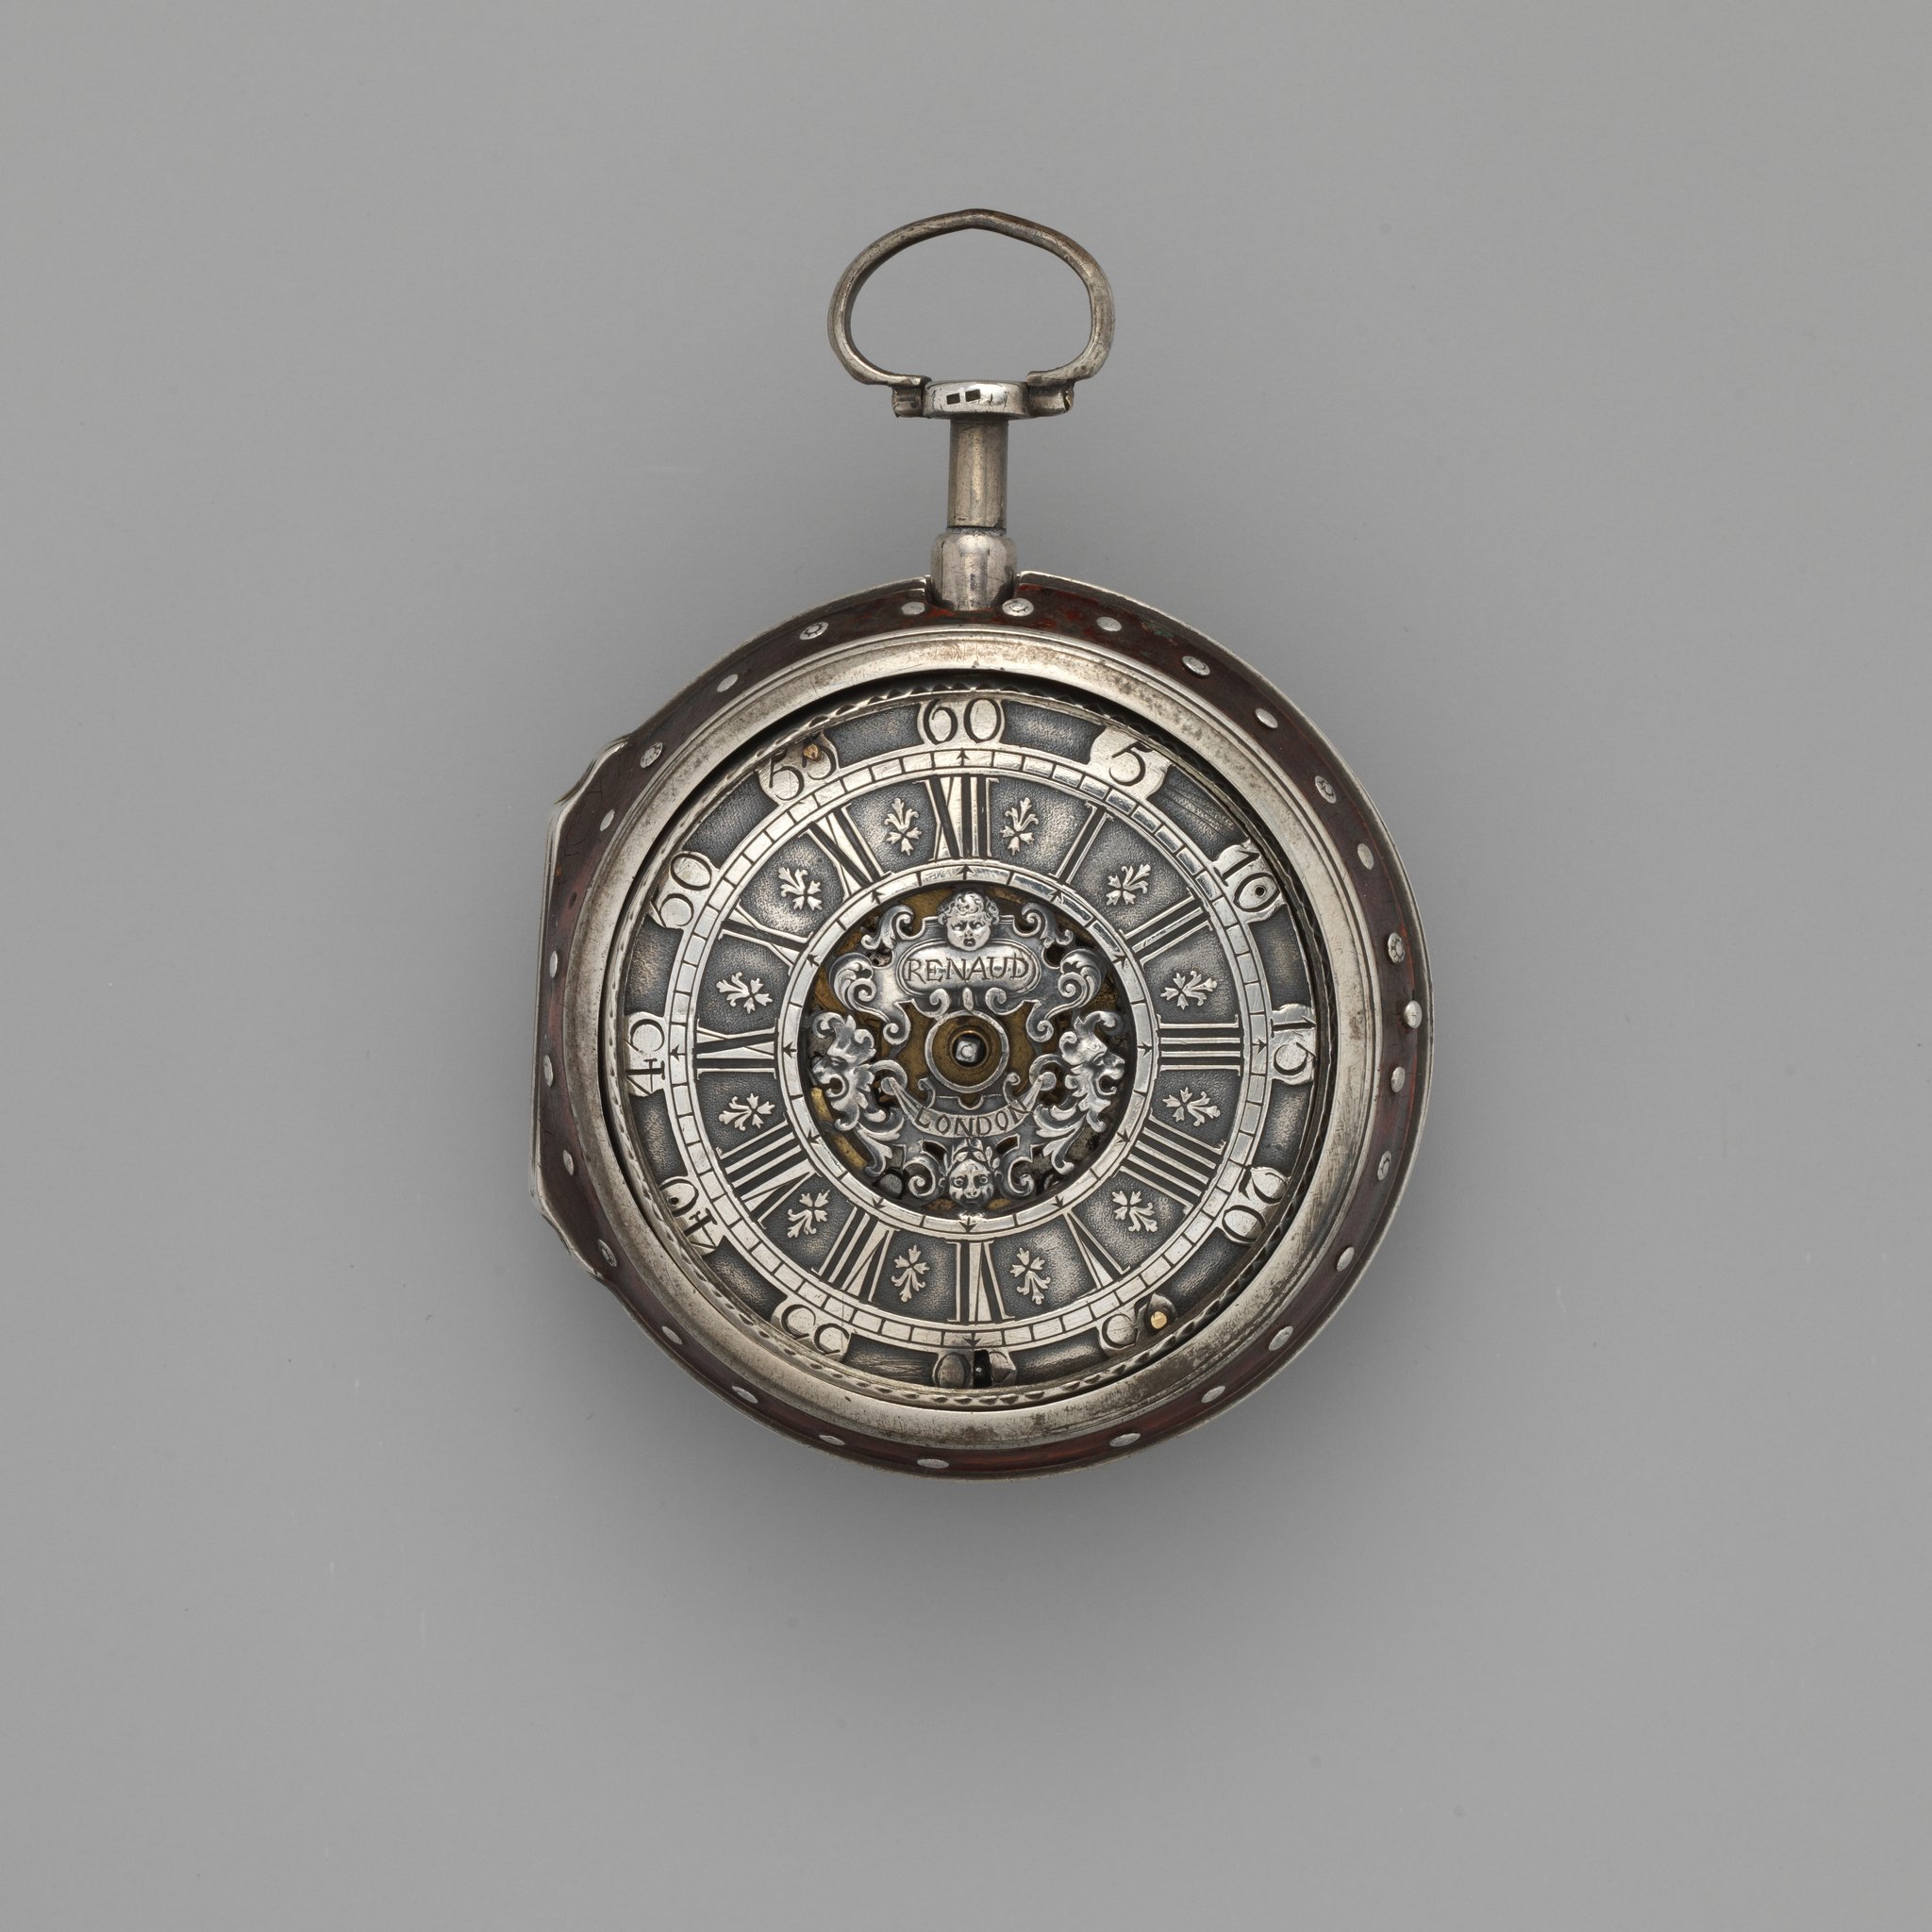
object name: repeater watch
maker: william webster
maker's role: maker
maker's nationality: british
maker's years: 1635-1735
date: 1701-1800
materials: copper, enamel, silver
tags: faces